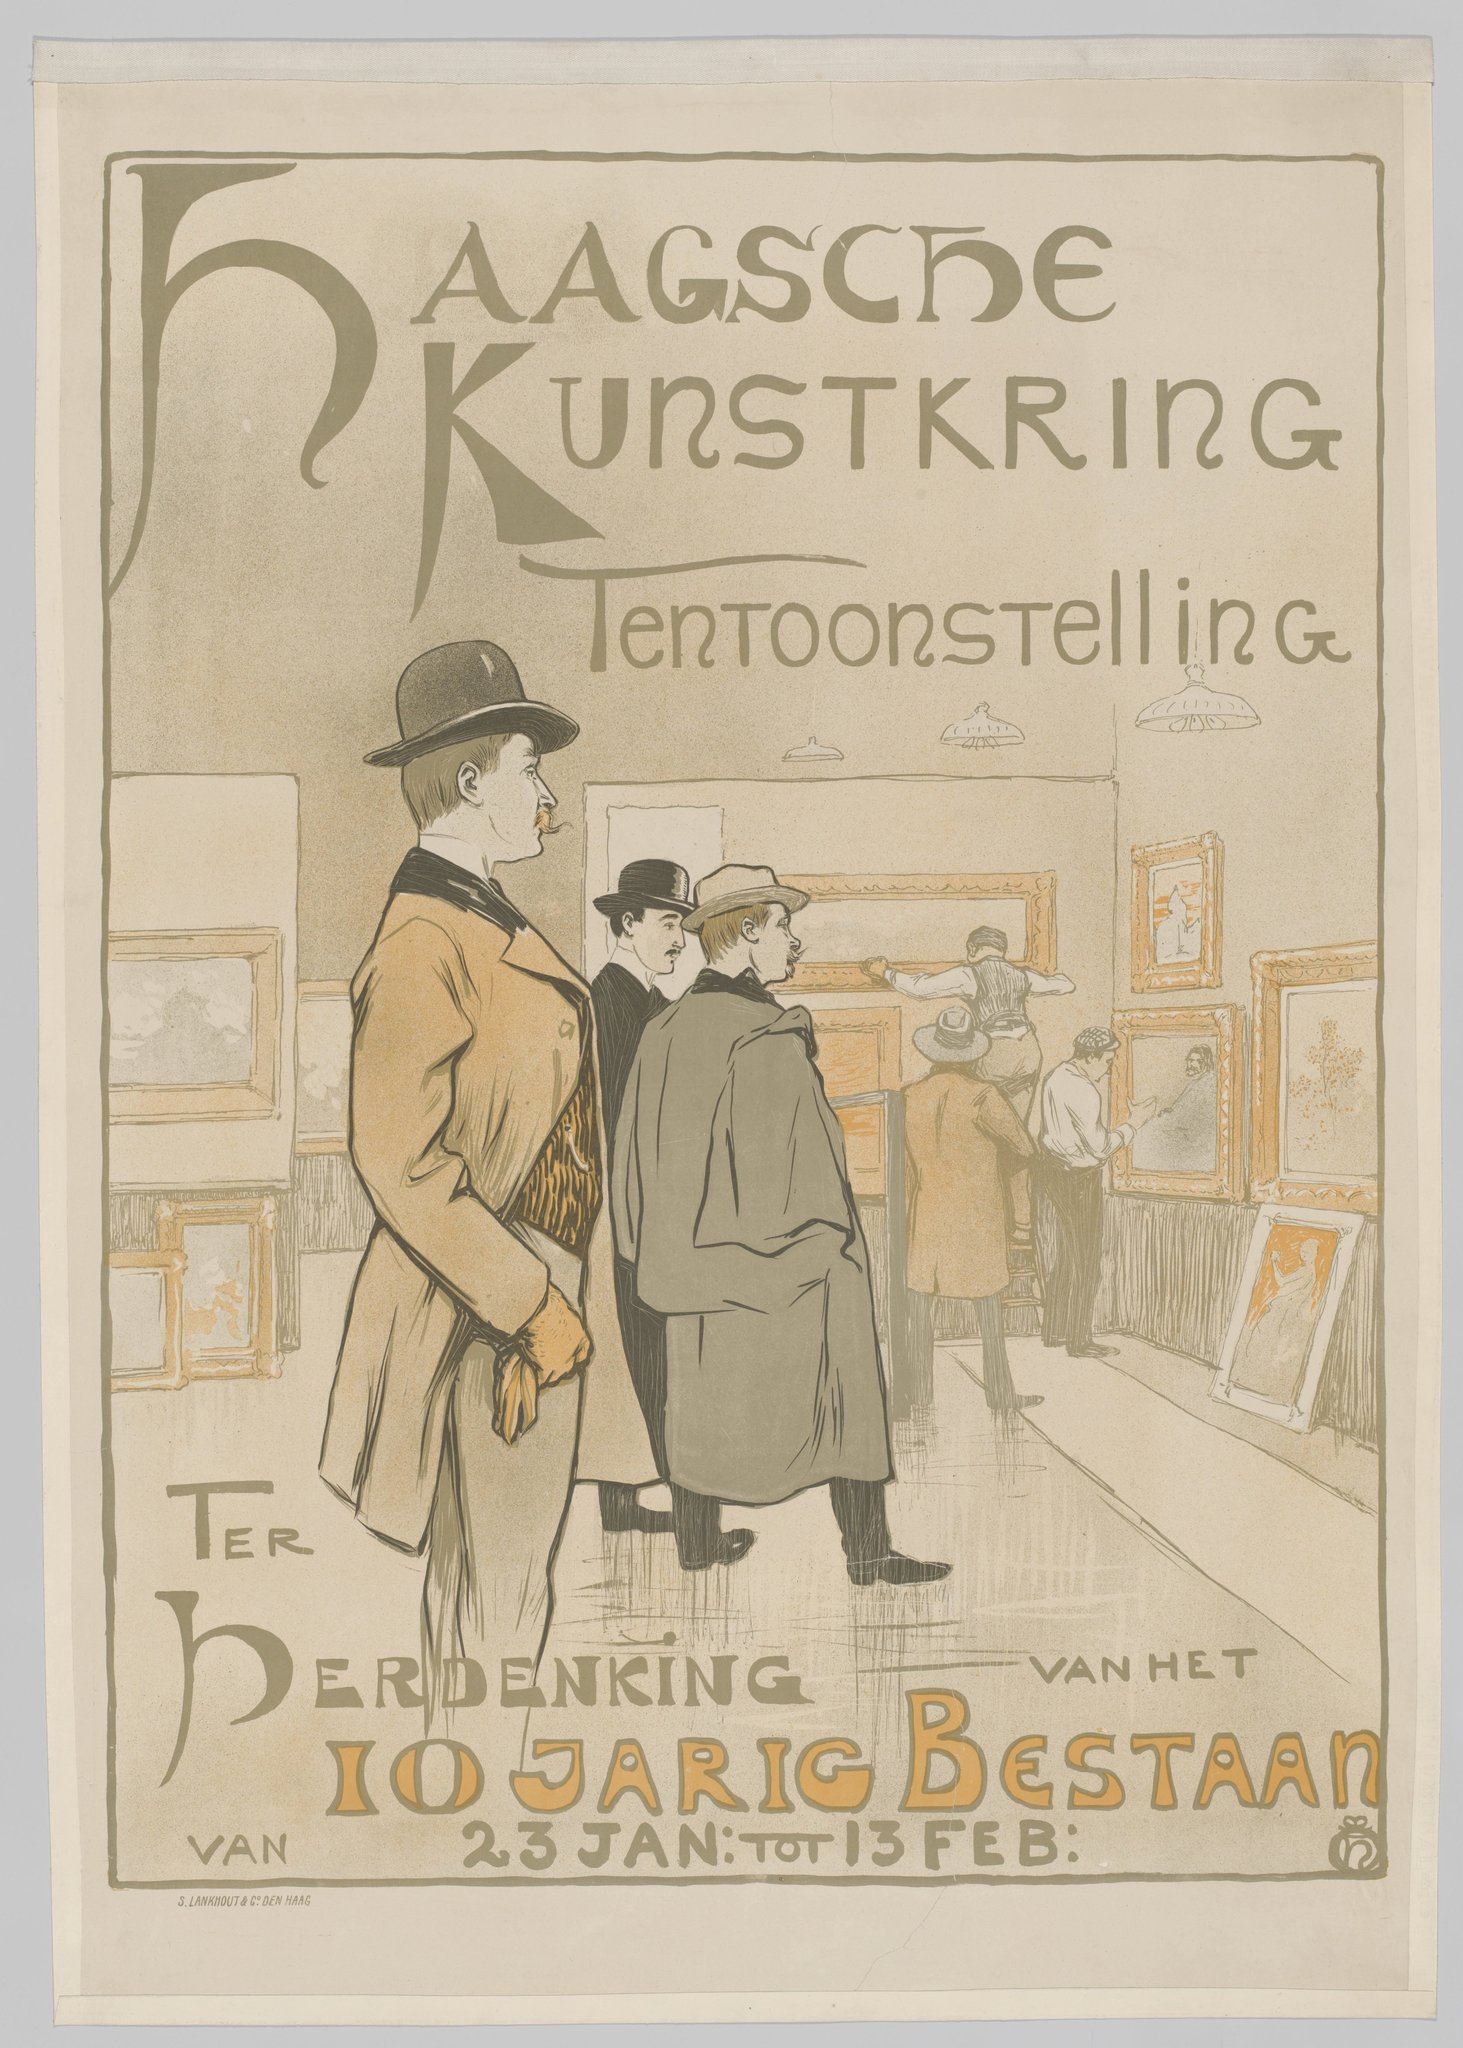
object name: poster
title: Haagsche Kunstkring Tentoonstelling ter herdenking van het 10 jarig bestaan van 23 jan tot 13 feb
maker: henricus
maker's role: draughtsman, print maker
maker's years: 1867-1921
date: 1913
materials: paper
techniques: lithograph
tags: temporary exhibition, 'salon'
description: Drie mannen staan in een ruimte waar schilderijen aan de muren hangen. Op de achtergrond zijn drie andere mannen aan het werk.